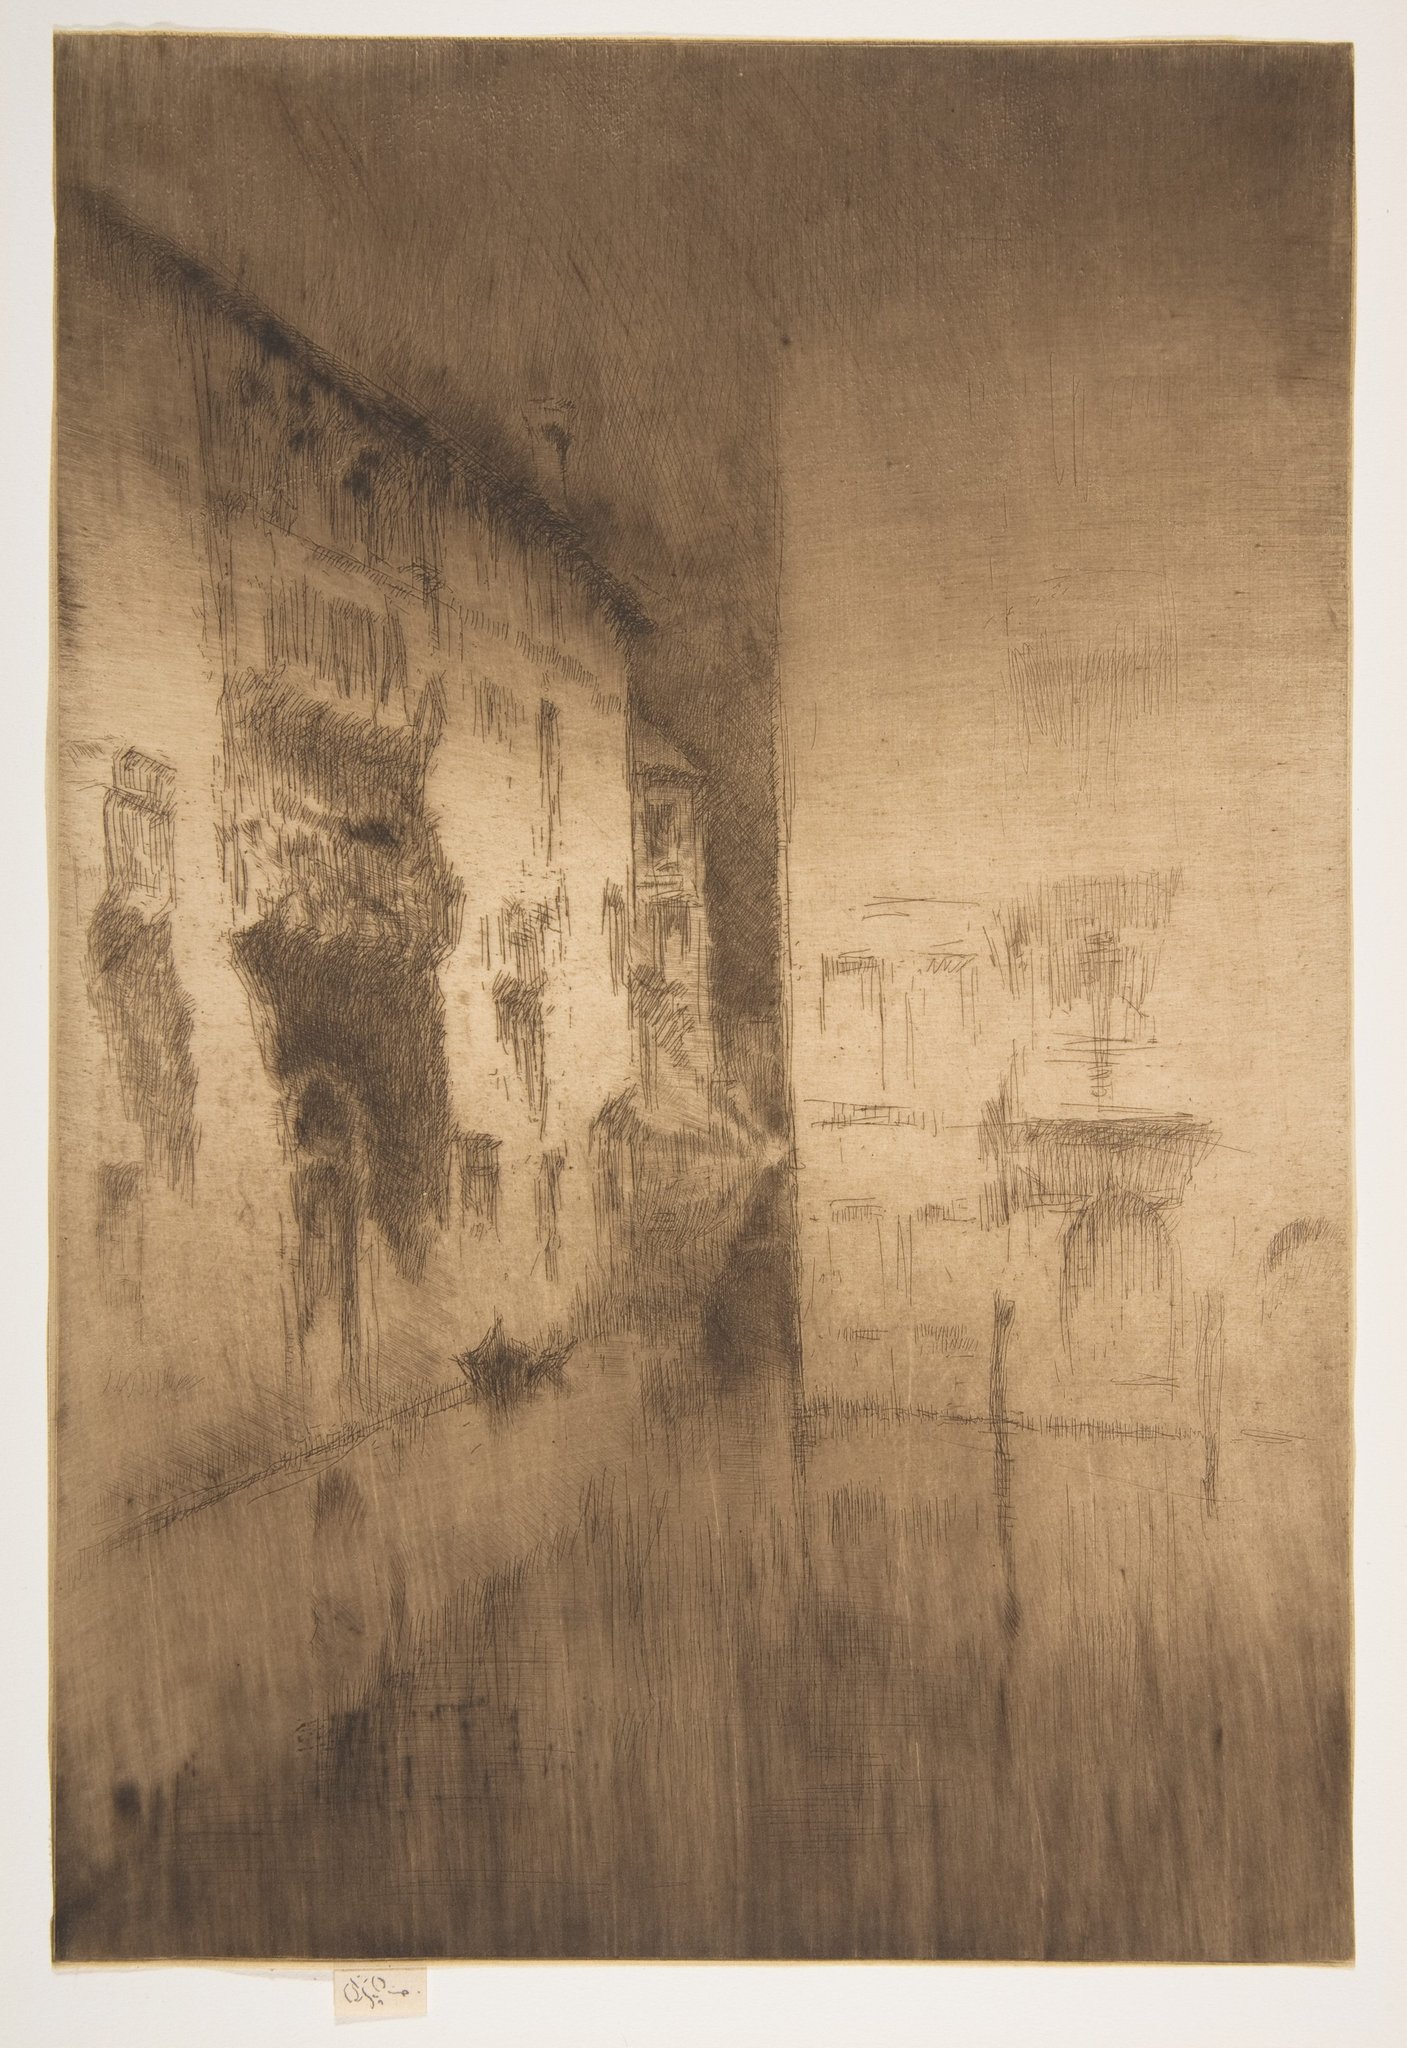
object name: print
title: Nocturne: Palaces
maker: james mcneill whistler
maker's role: artist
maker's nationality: american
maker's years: 1834-1903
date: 1879-1880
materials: ink, paper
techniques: drypoint, etching, printing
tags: venice